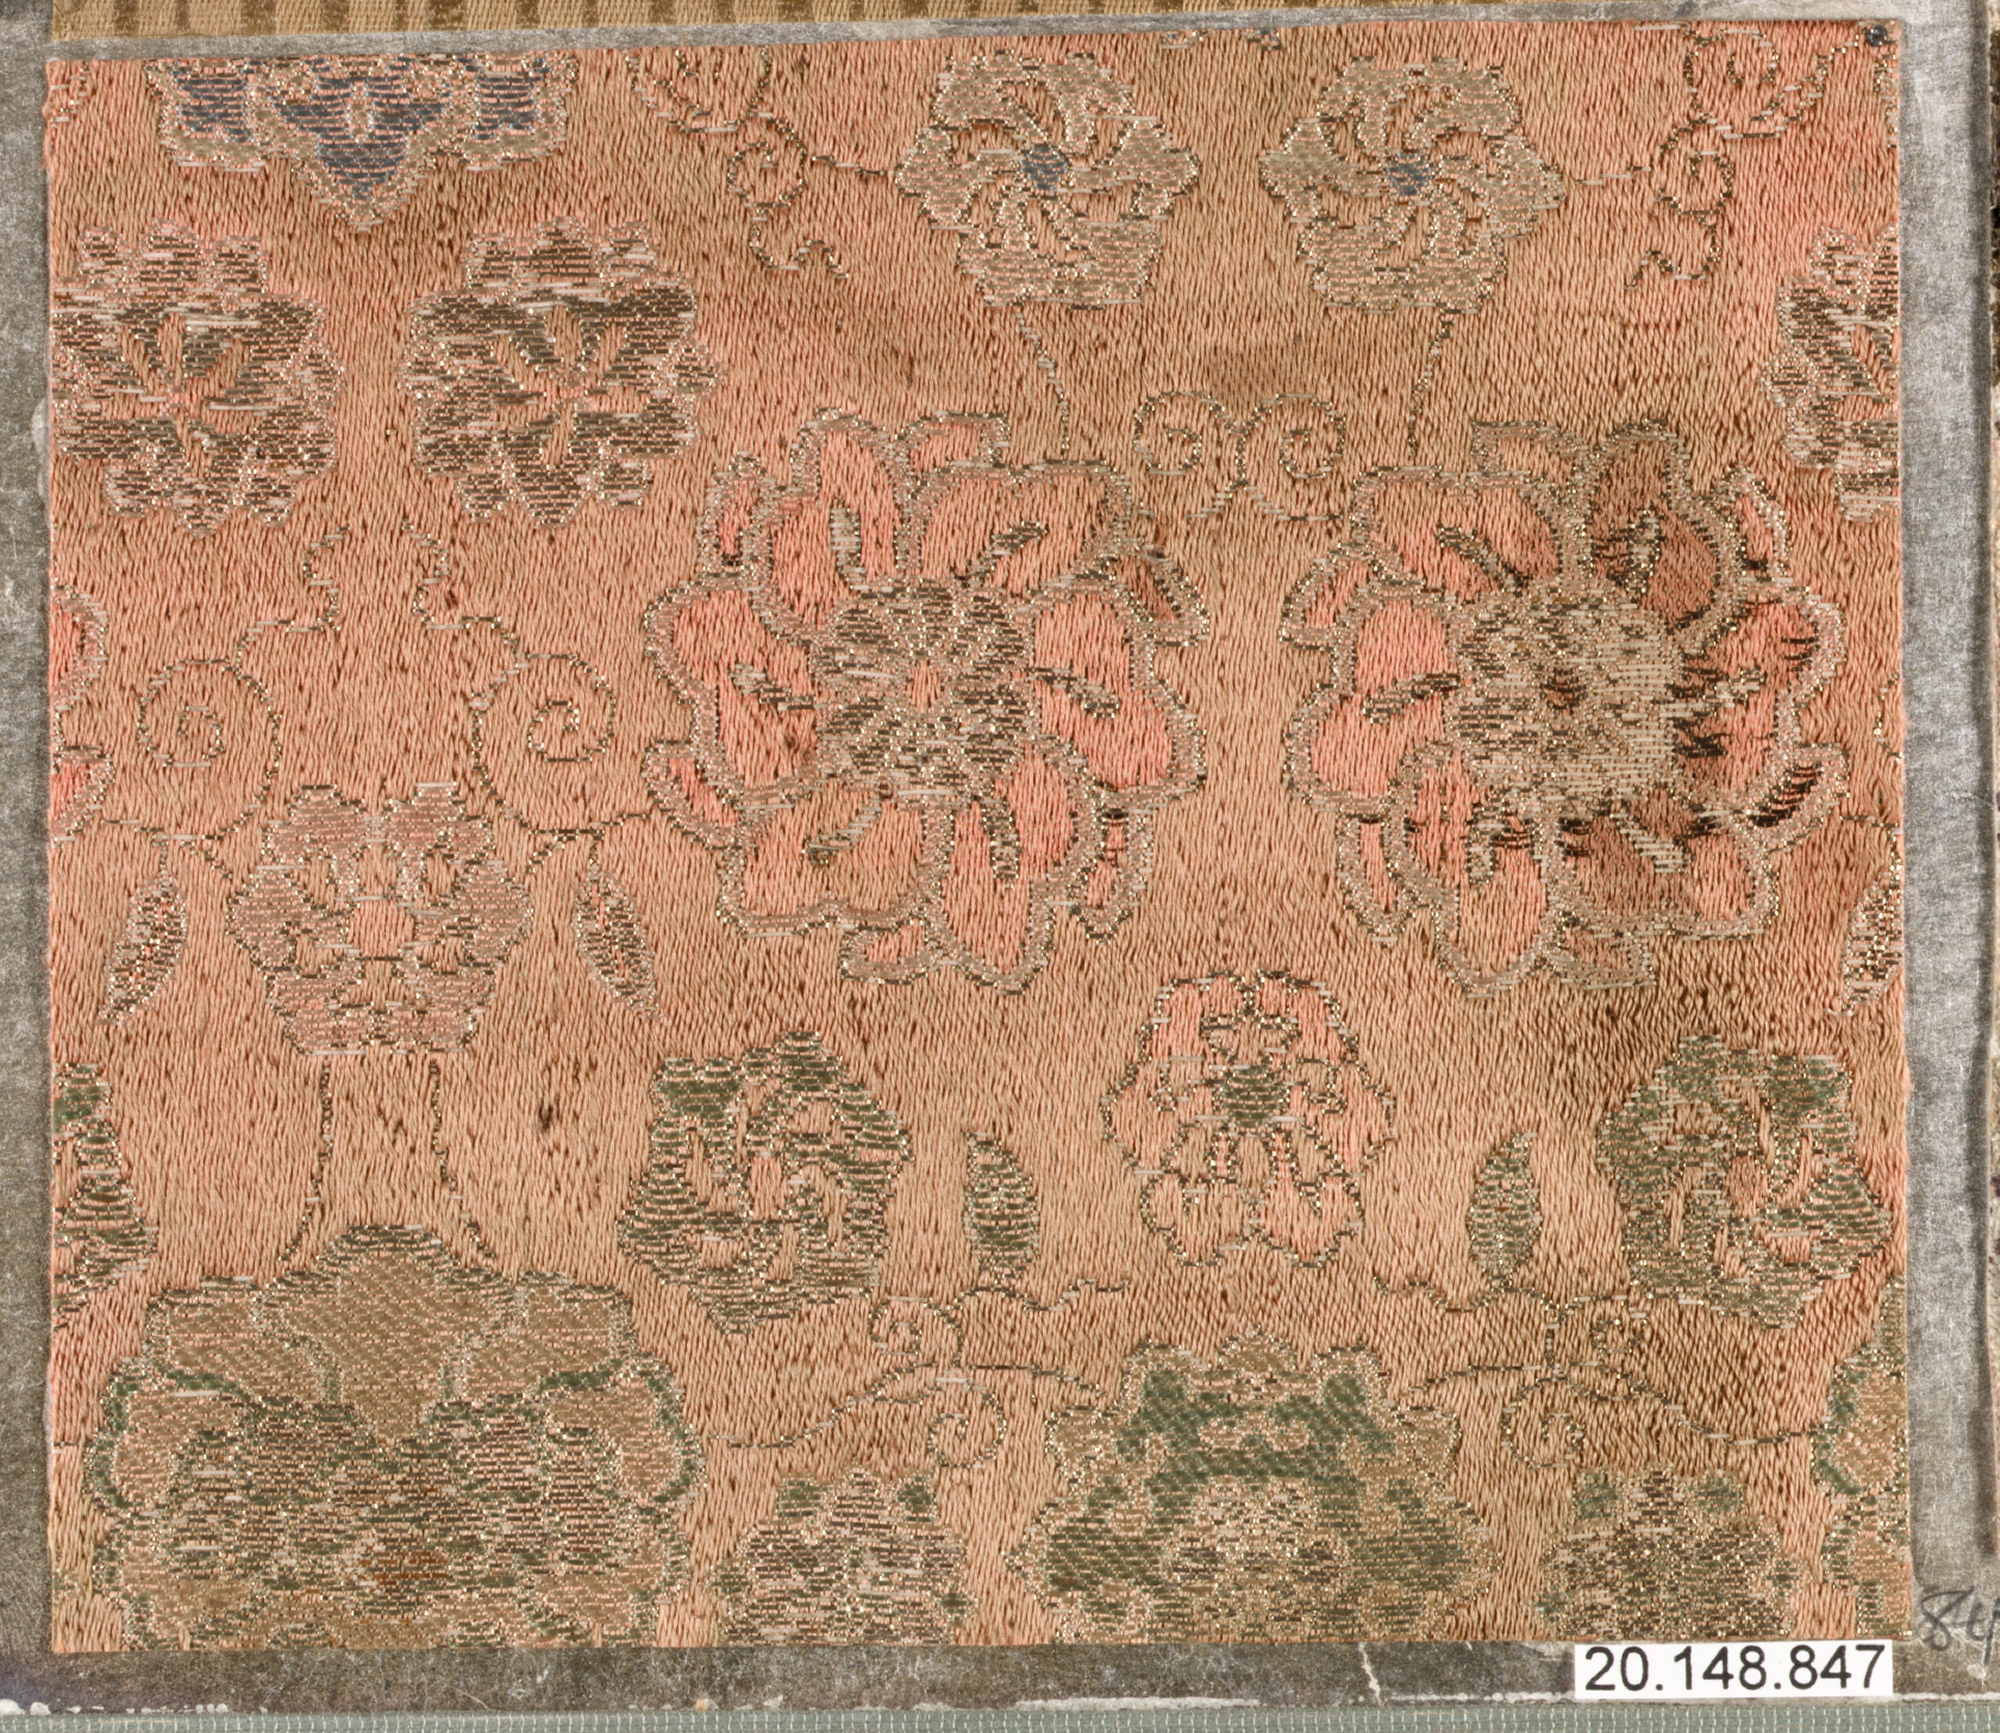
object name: piece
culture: japanese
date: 1601-1700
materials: silk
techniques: compound weave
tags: flowers